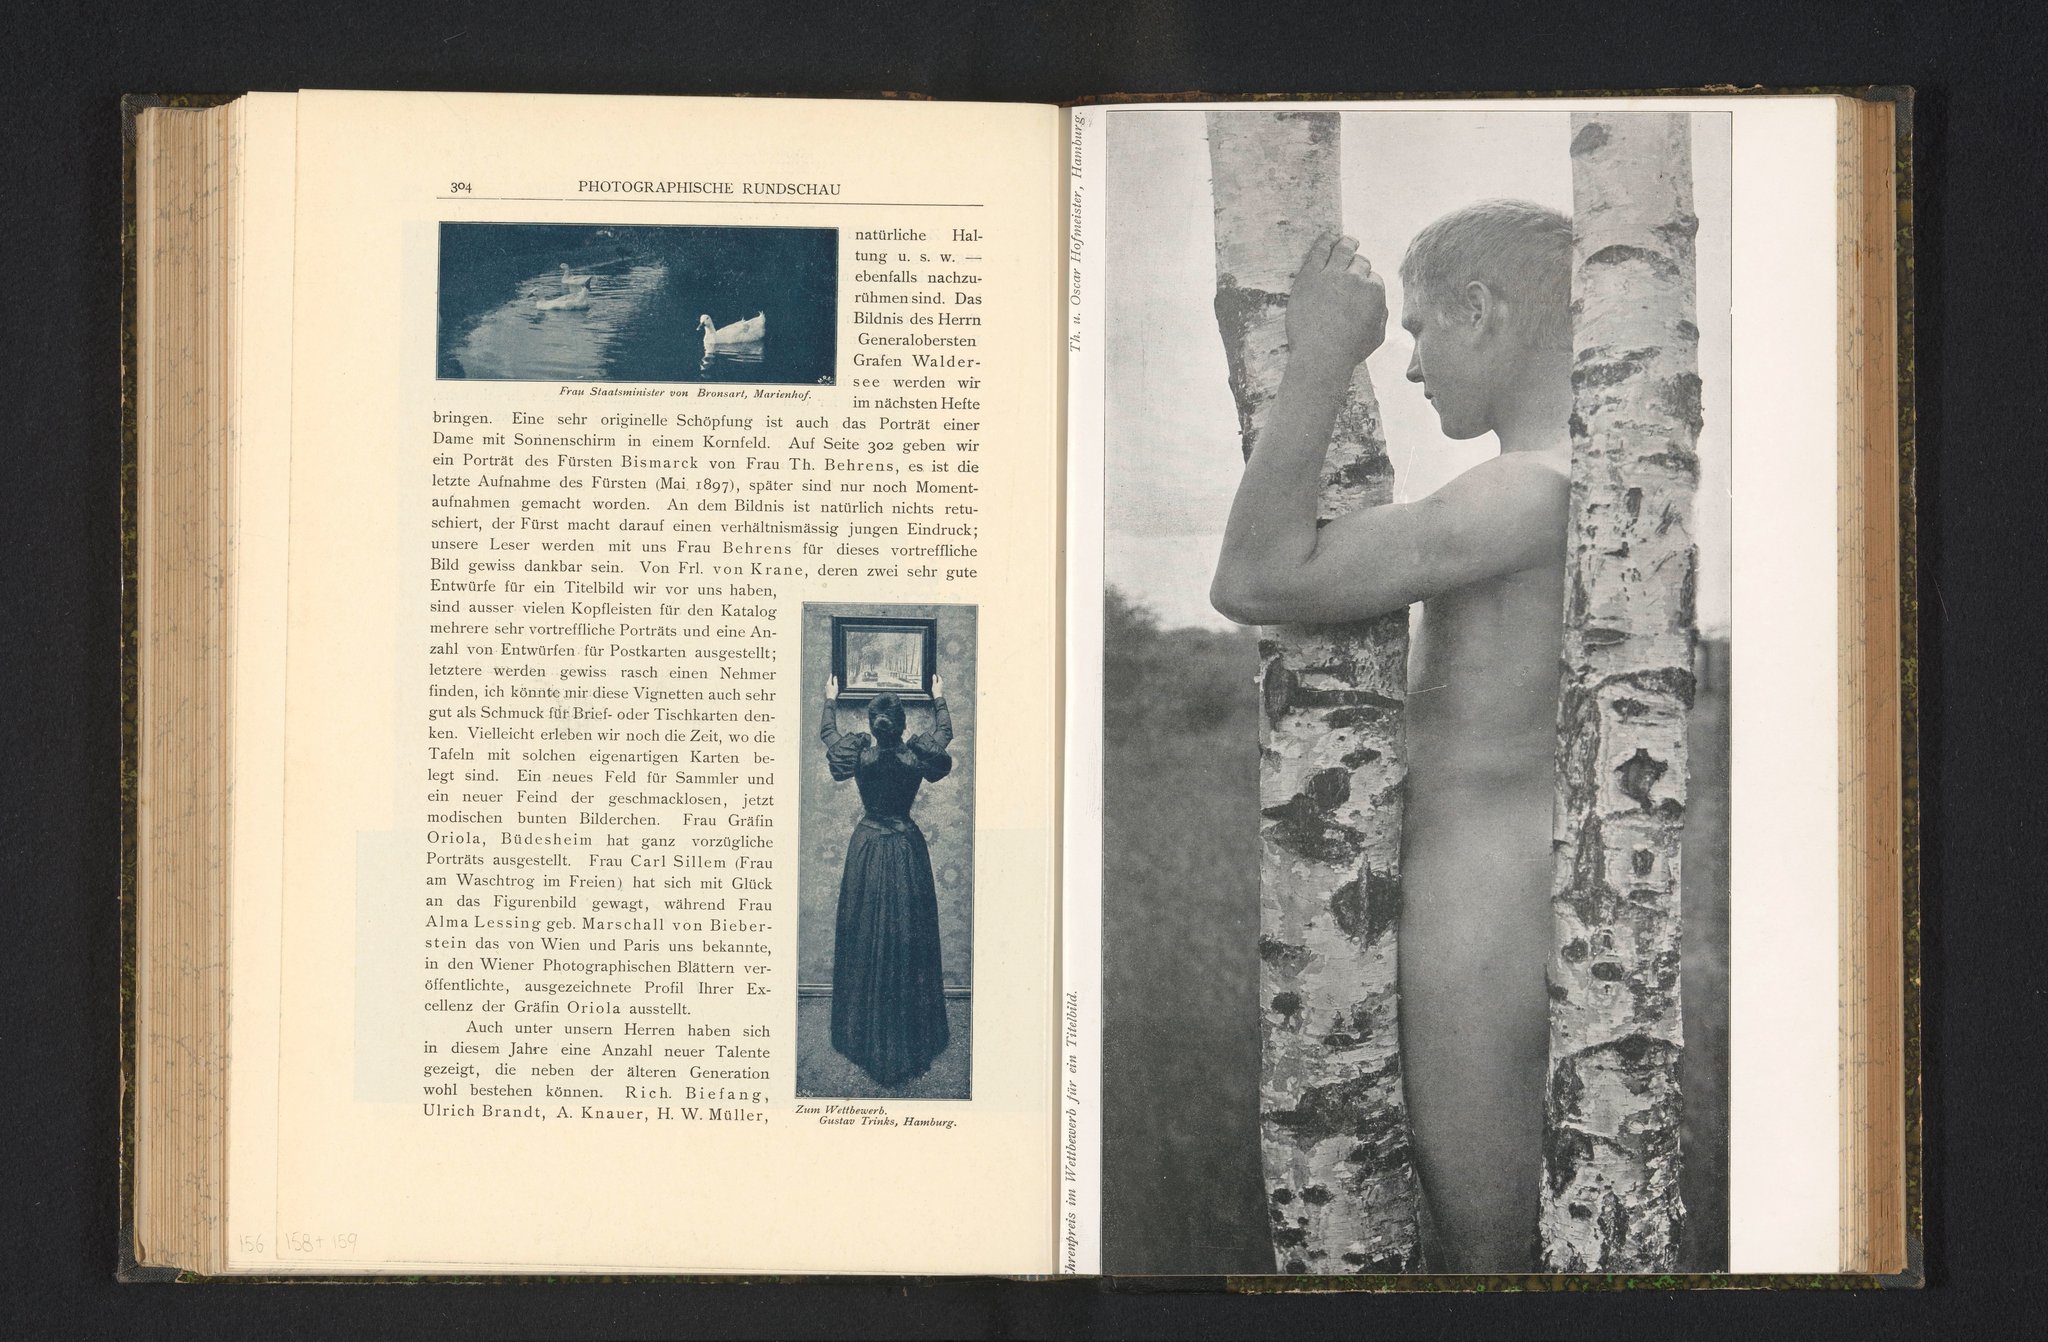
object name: photomechanical print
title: Gezicht op een onbekende vrouw die een schilderij ophangt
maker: gustav eduard bernhard trinks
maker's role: fotograaf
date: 1893-1898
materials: paper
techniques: autotype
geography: berlin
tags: adult woman, picture, painting, historical persons not known by name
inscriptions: monogram: ‘MR&C’